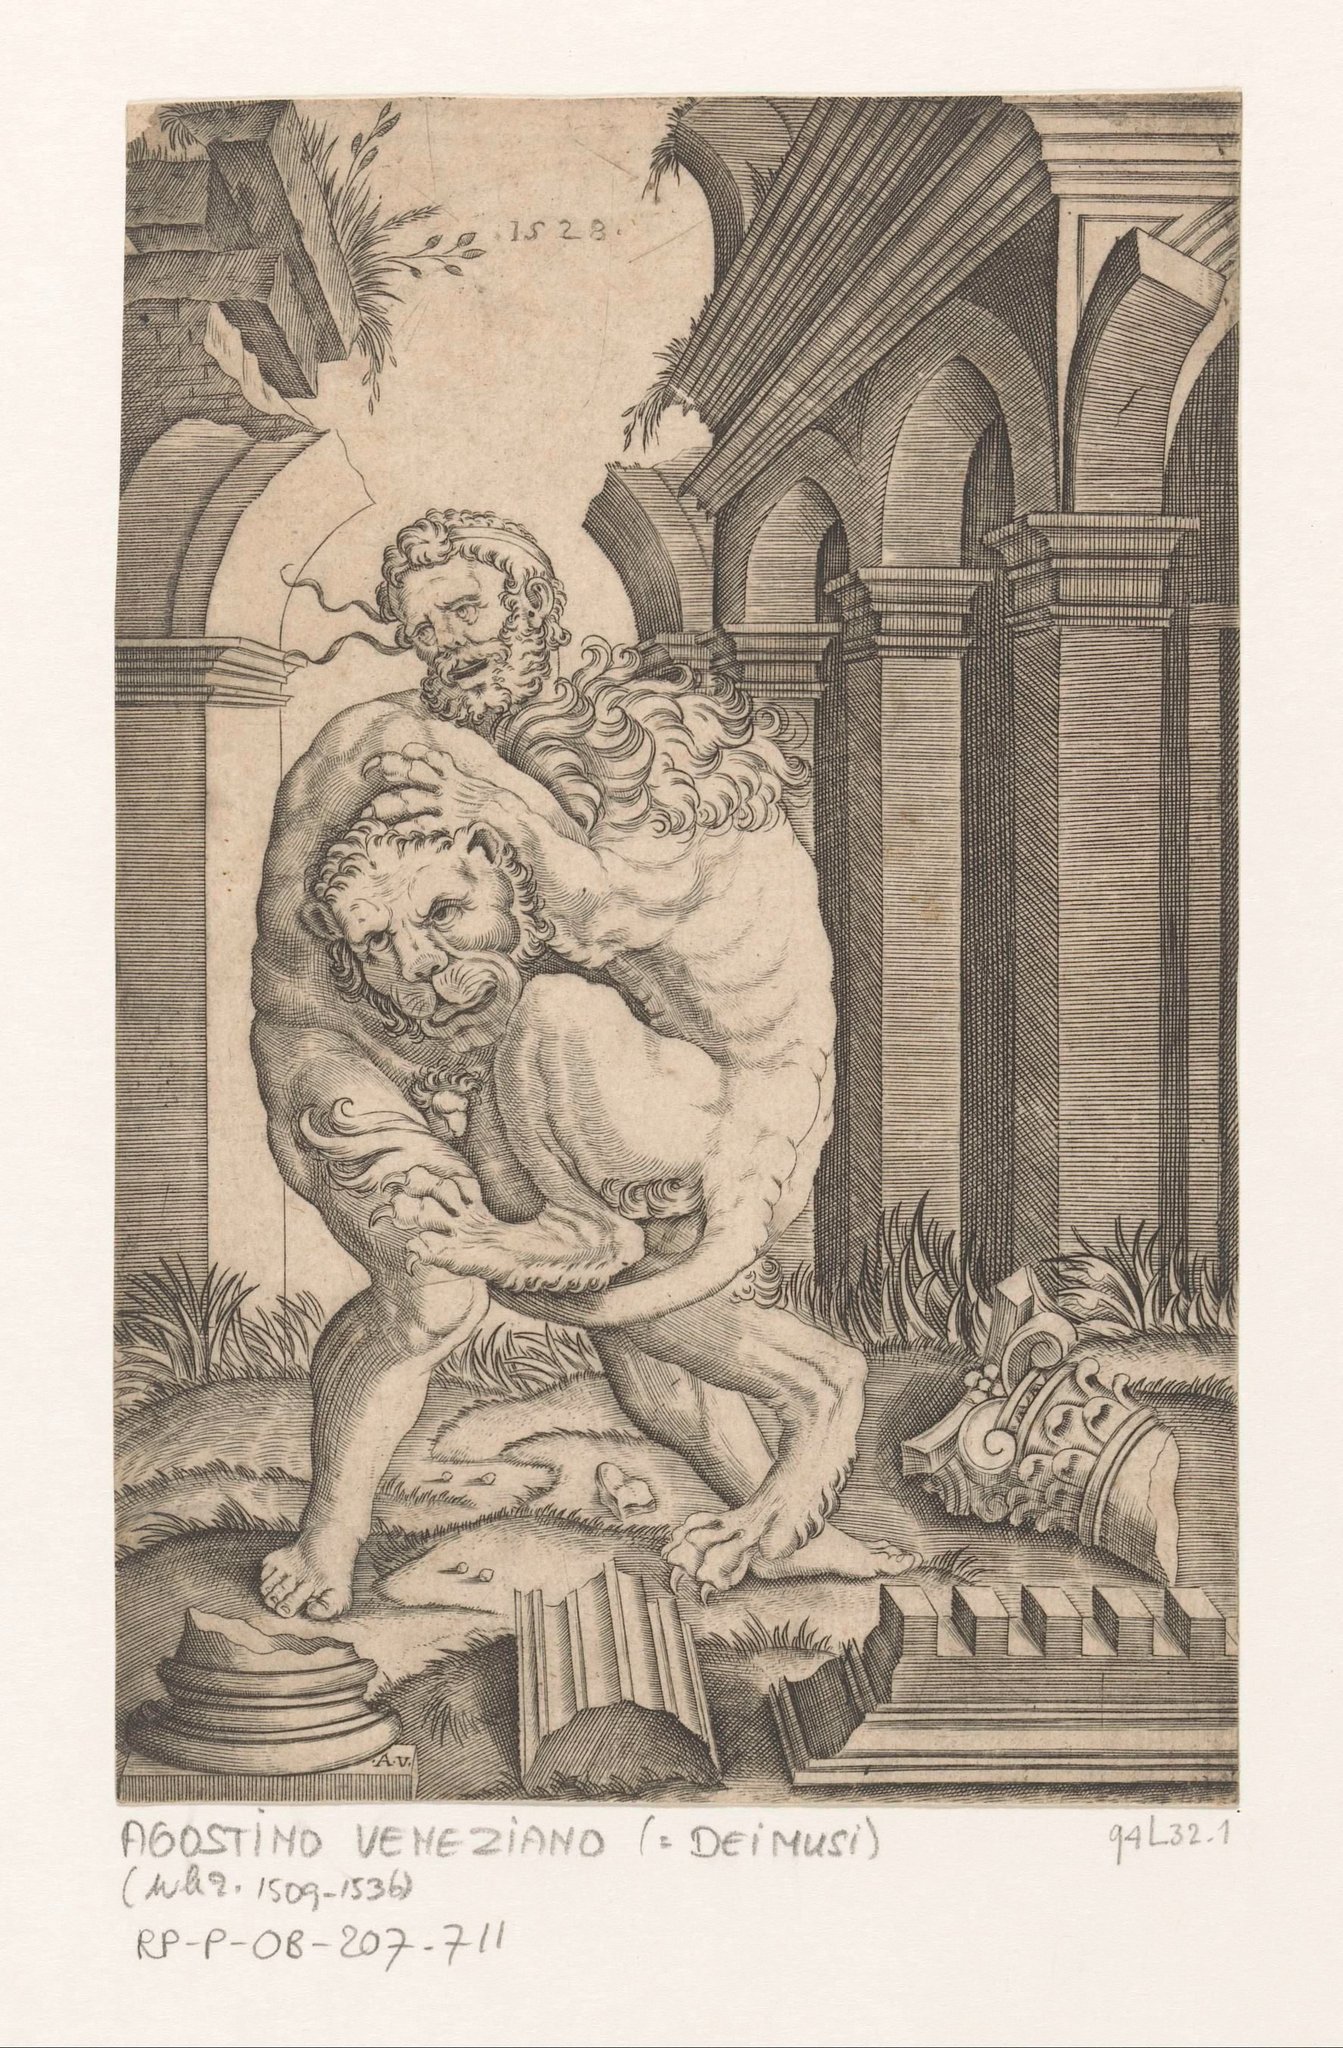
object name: print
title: Hercules en de Nemeïsche leeuw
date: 1528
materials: paper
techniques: engraving, etching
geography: italy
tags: ruin of a building ~ architecture, (1) hercules chokes the nemean lion with his arms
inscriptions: collector's mark: Lugt 2228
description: Tussen de antieke ruïnes staat Hercules terwijl hij de Nemeïsche leeuw vasthoudt. Met zijn armen omklemt hij de hals van de leeuw om hem te wurgen.